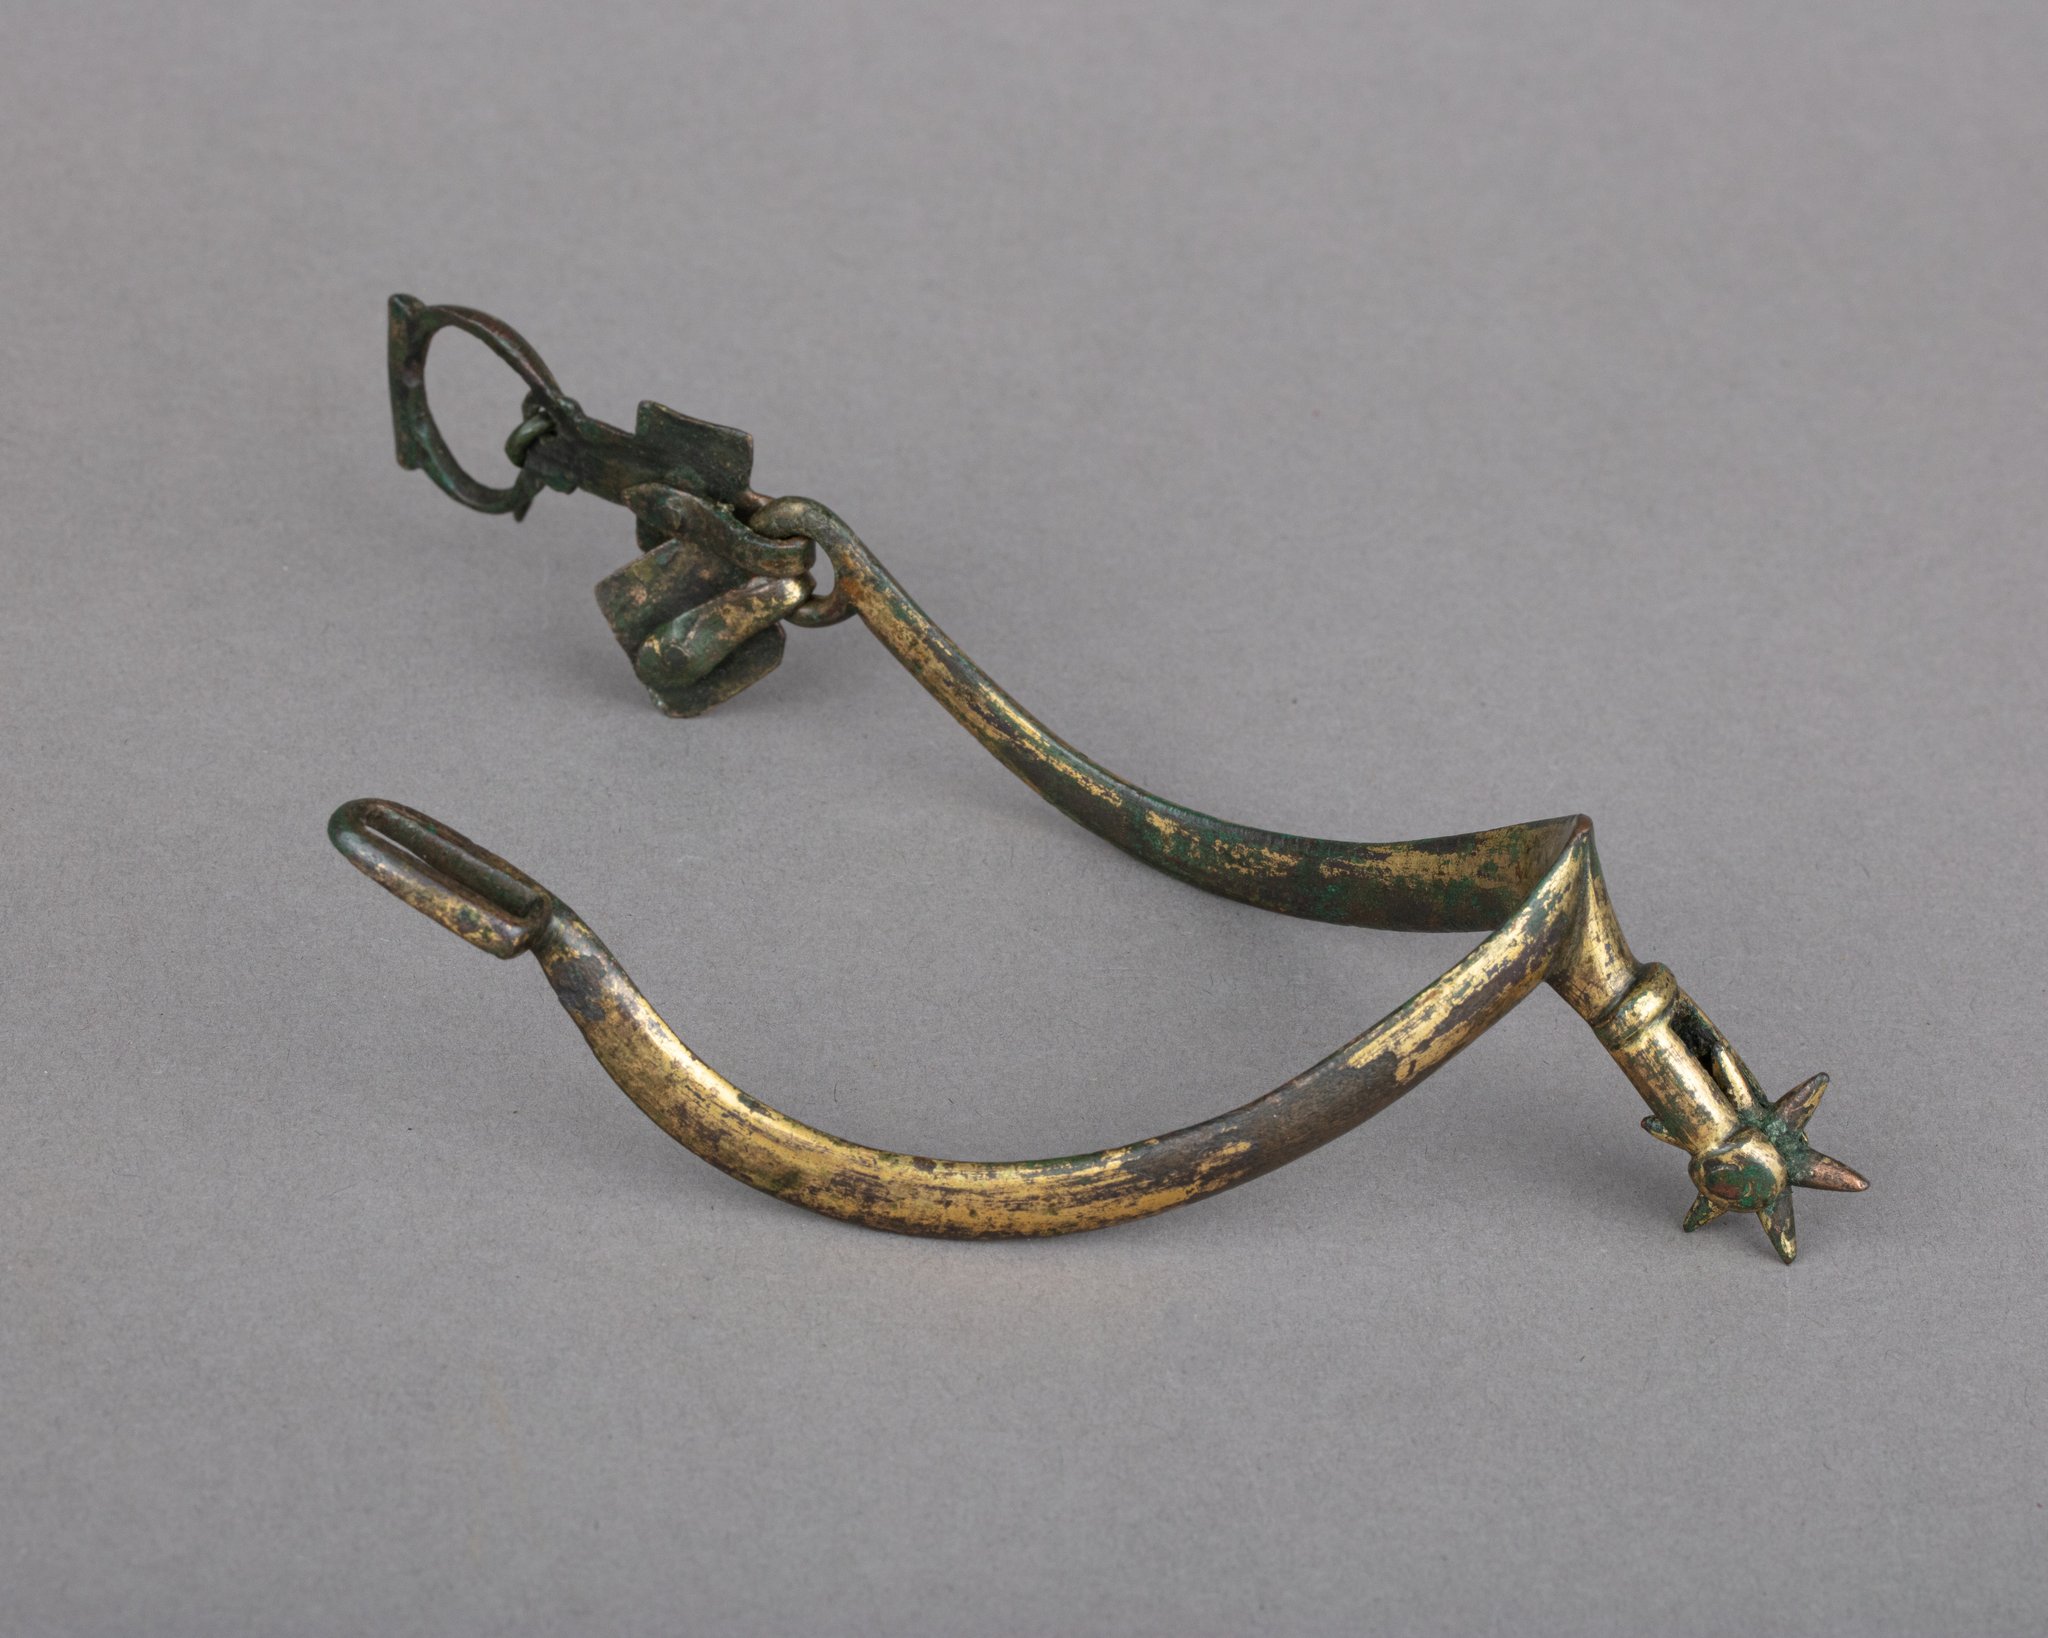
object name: spur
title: Rowel Spur (Right)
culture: french or italian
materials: copper alloy, gold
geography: france